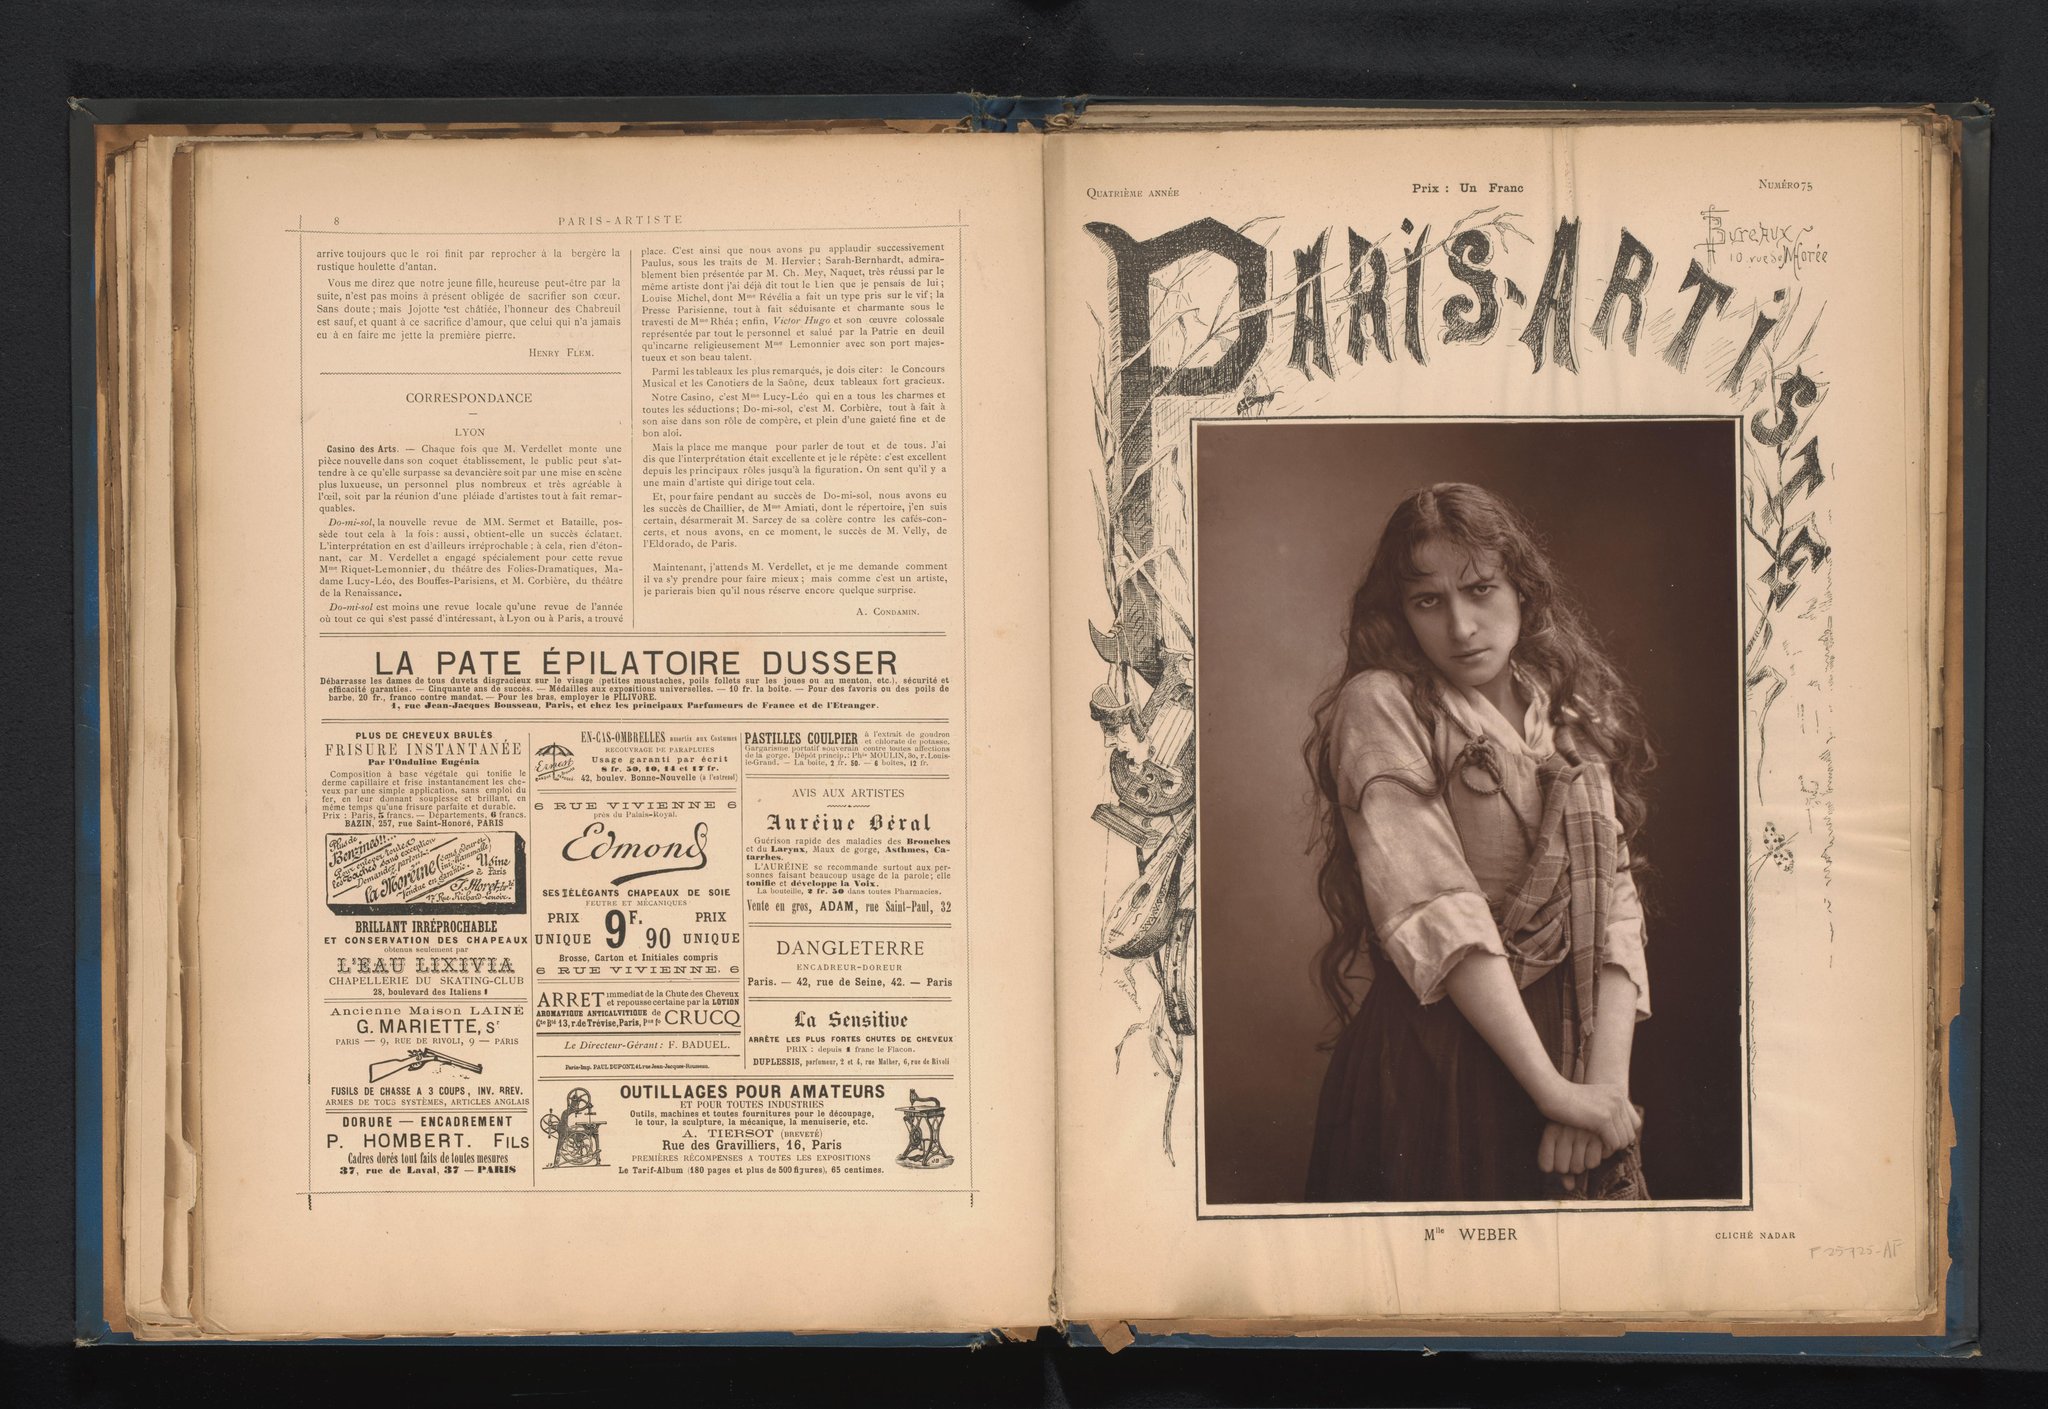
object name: page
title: Portret van Eugénie Caroline Weber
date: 1880-1886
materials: paper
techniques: woodburytype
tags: paris, historical persons - bb - woman, portrait of actor, actress